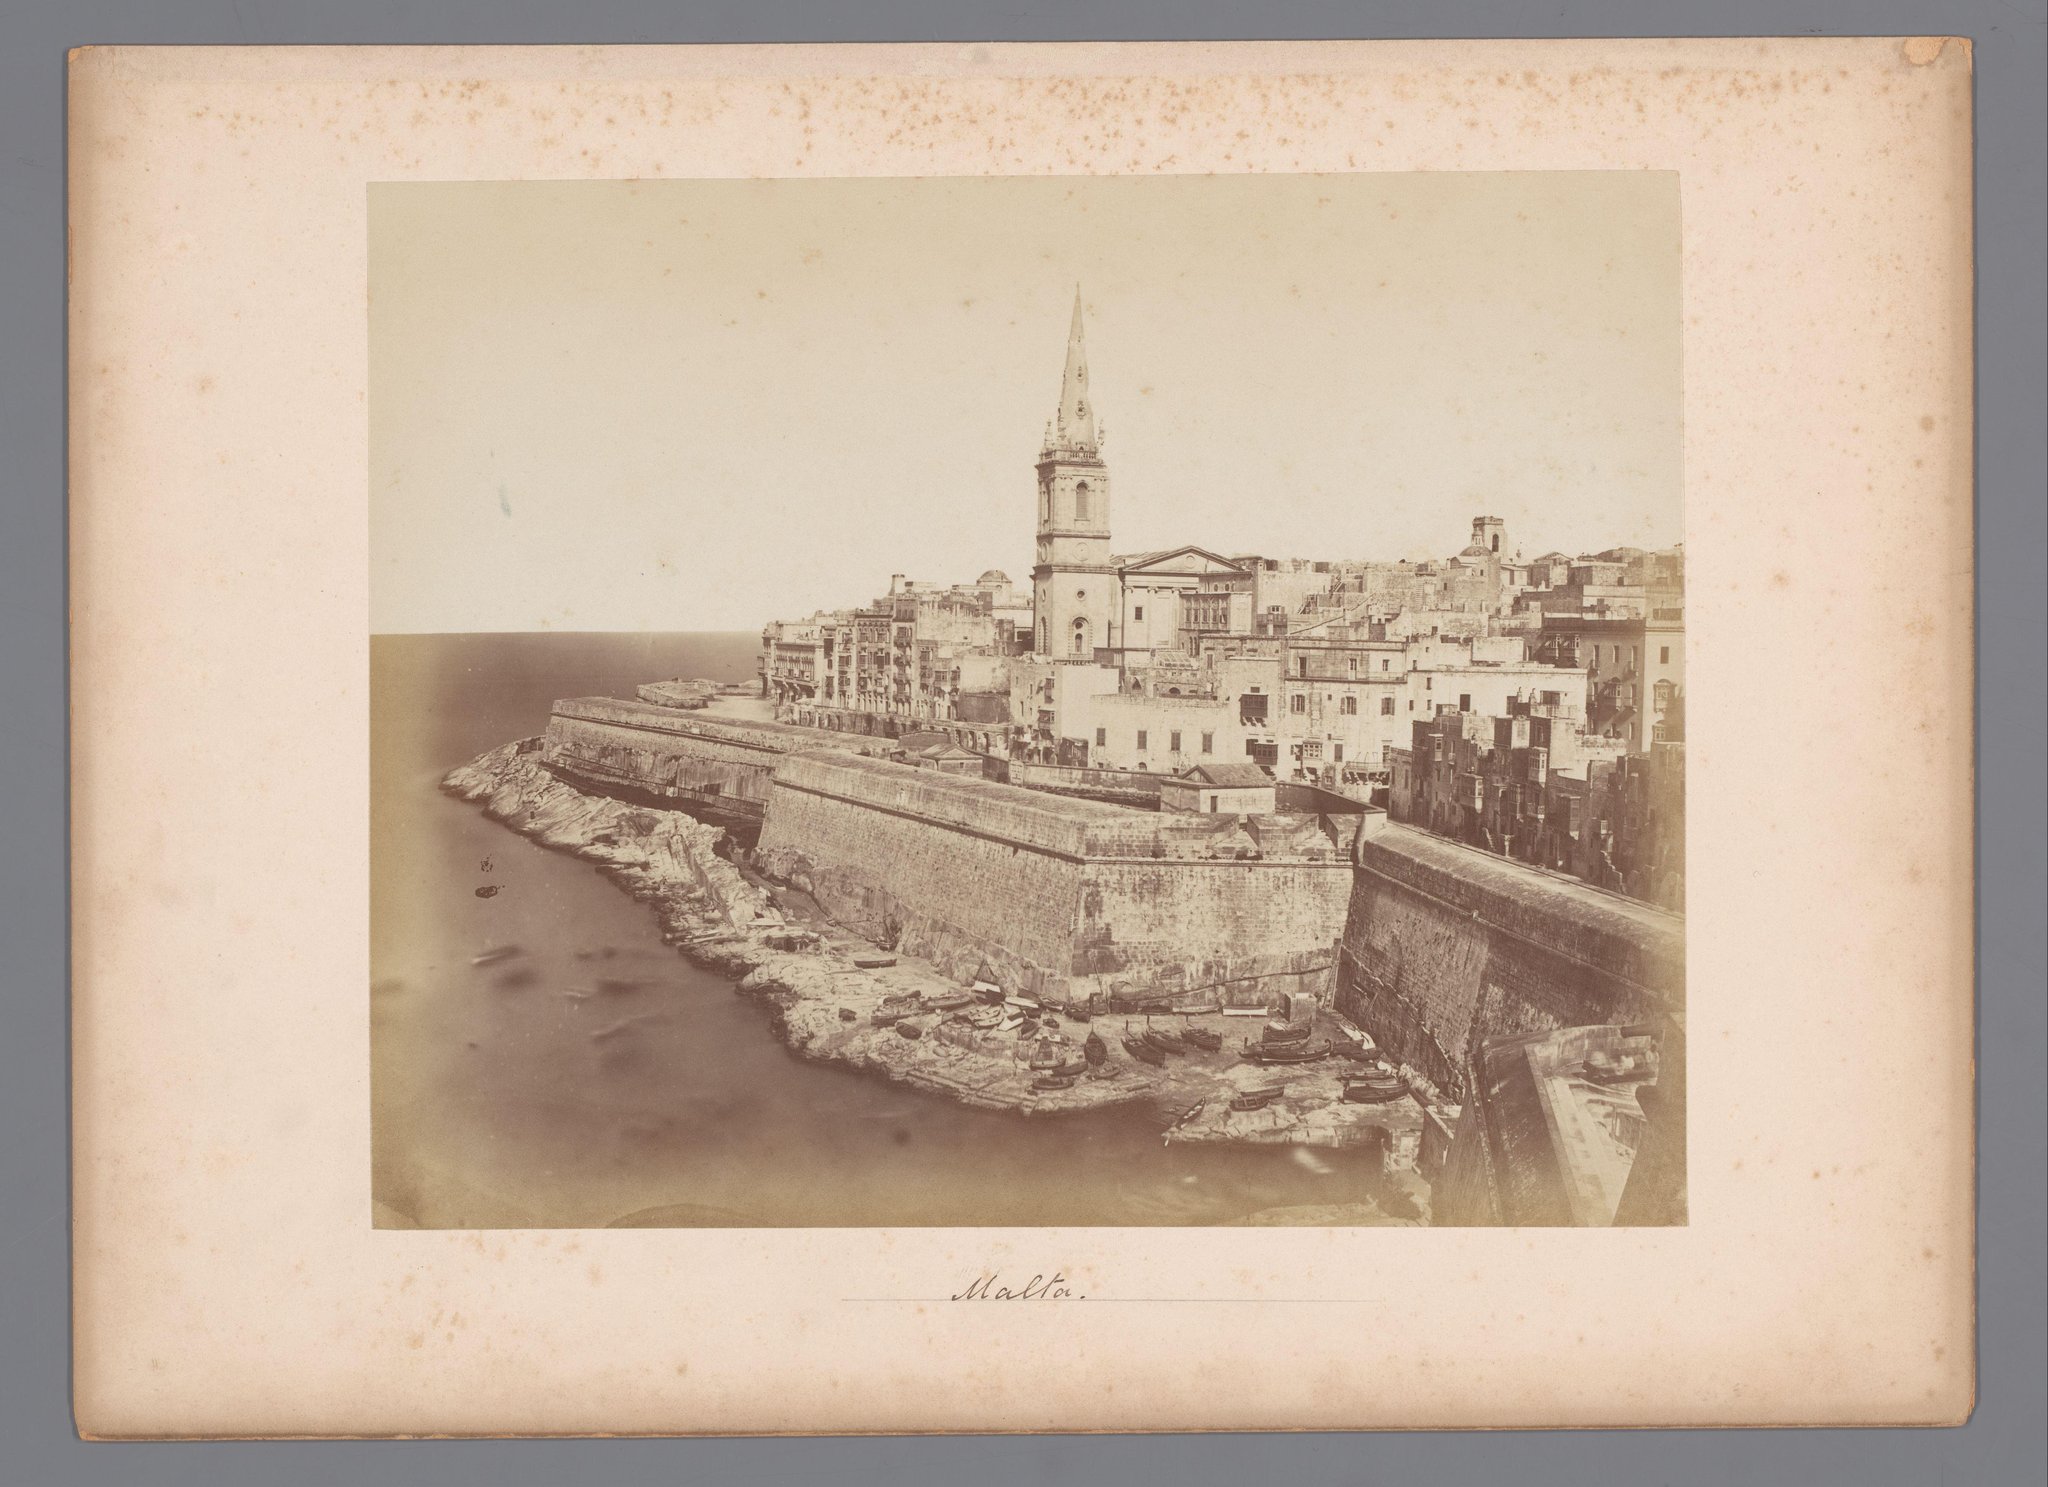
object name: photograph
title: Malta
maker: Anonymous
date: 1880-1900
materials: cardboard, photographic support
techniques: albumen print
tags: malta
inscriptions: inscription: ‘Malta’, inscription: ‘Foto: Micallef e Borg [?]’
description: Malta is een dwergstaat gelegen in de Middellandse Zee die bestaat uit de eilanden Malta, Gozo, Comino en de kleine onbewoonde eilanden Manoel Island, Cominotto, Filfla, Fungus Rock en de Saint Paul's Islands.